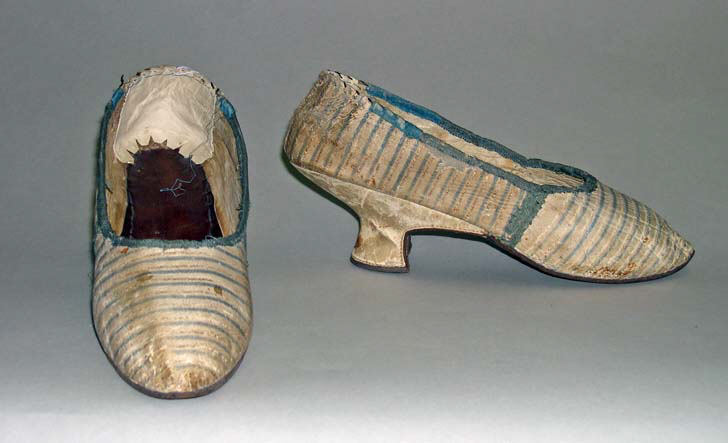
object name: slipper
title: Slippers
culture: american or european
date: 1780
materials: leather